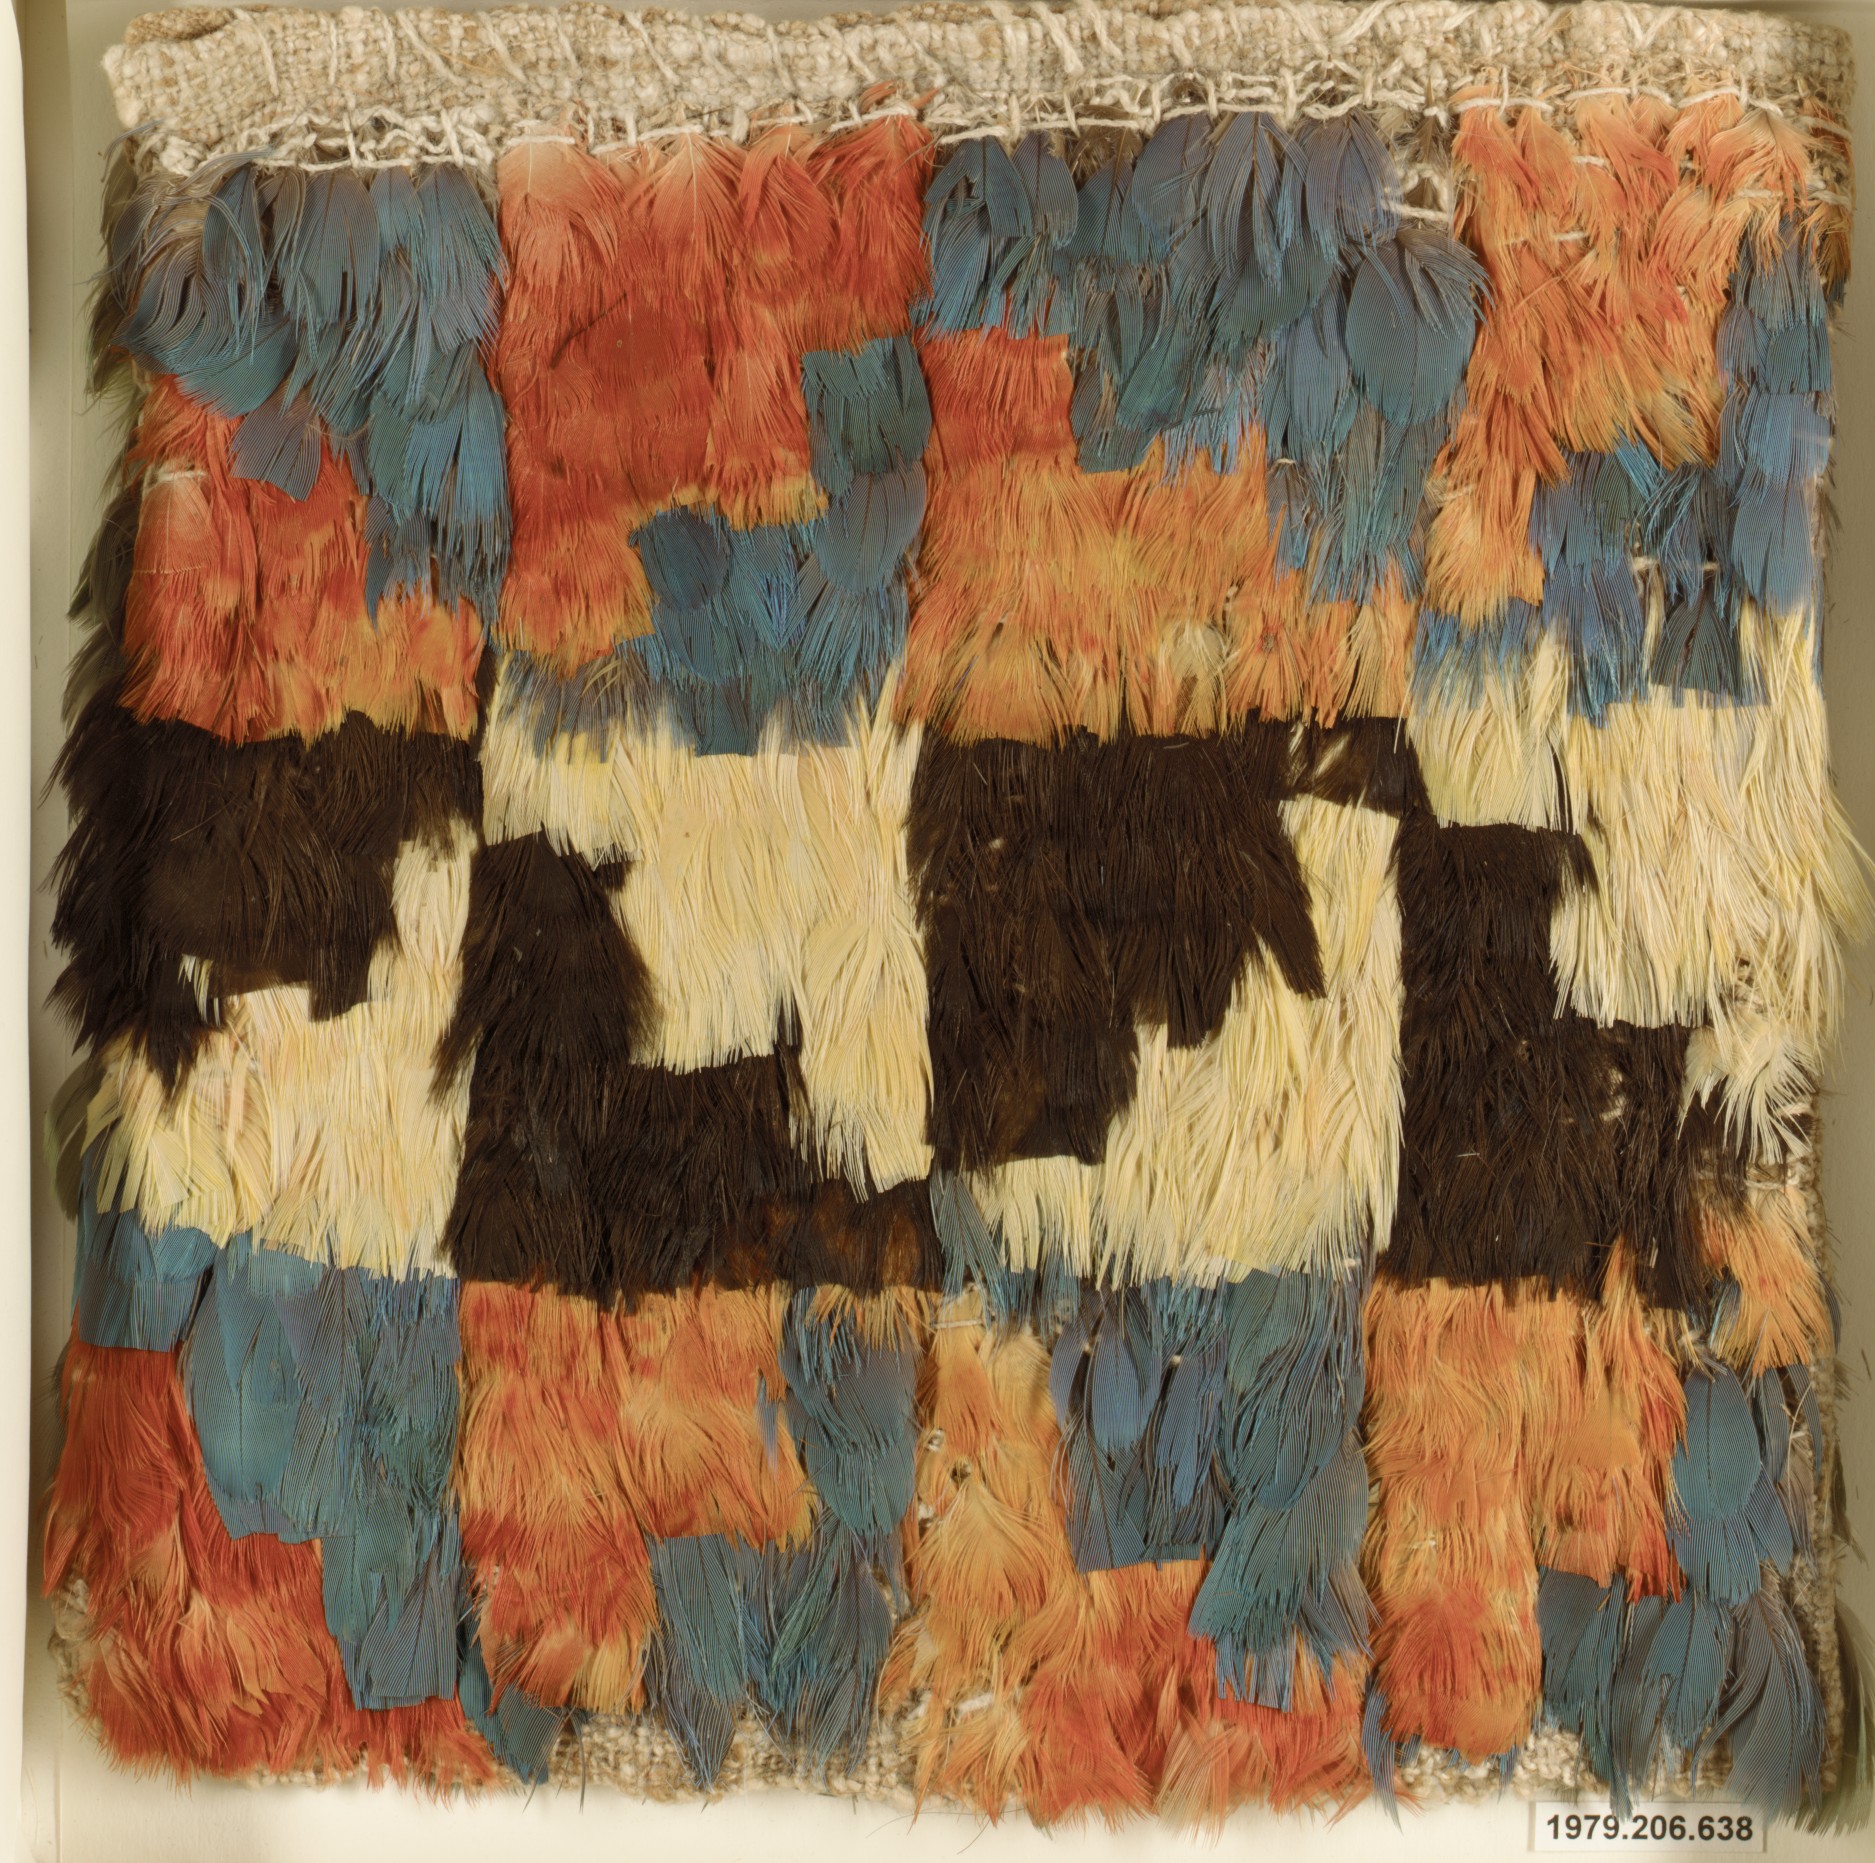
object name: miniature dress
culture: ica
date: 1101-1300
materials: cotton, feather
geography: peru